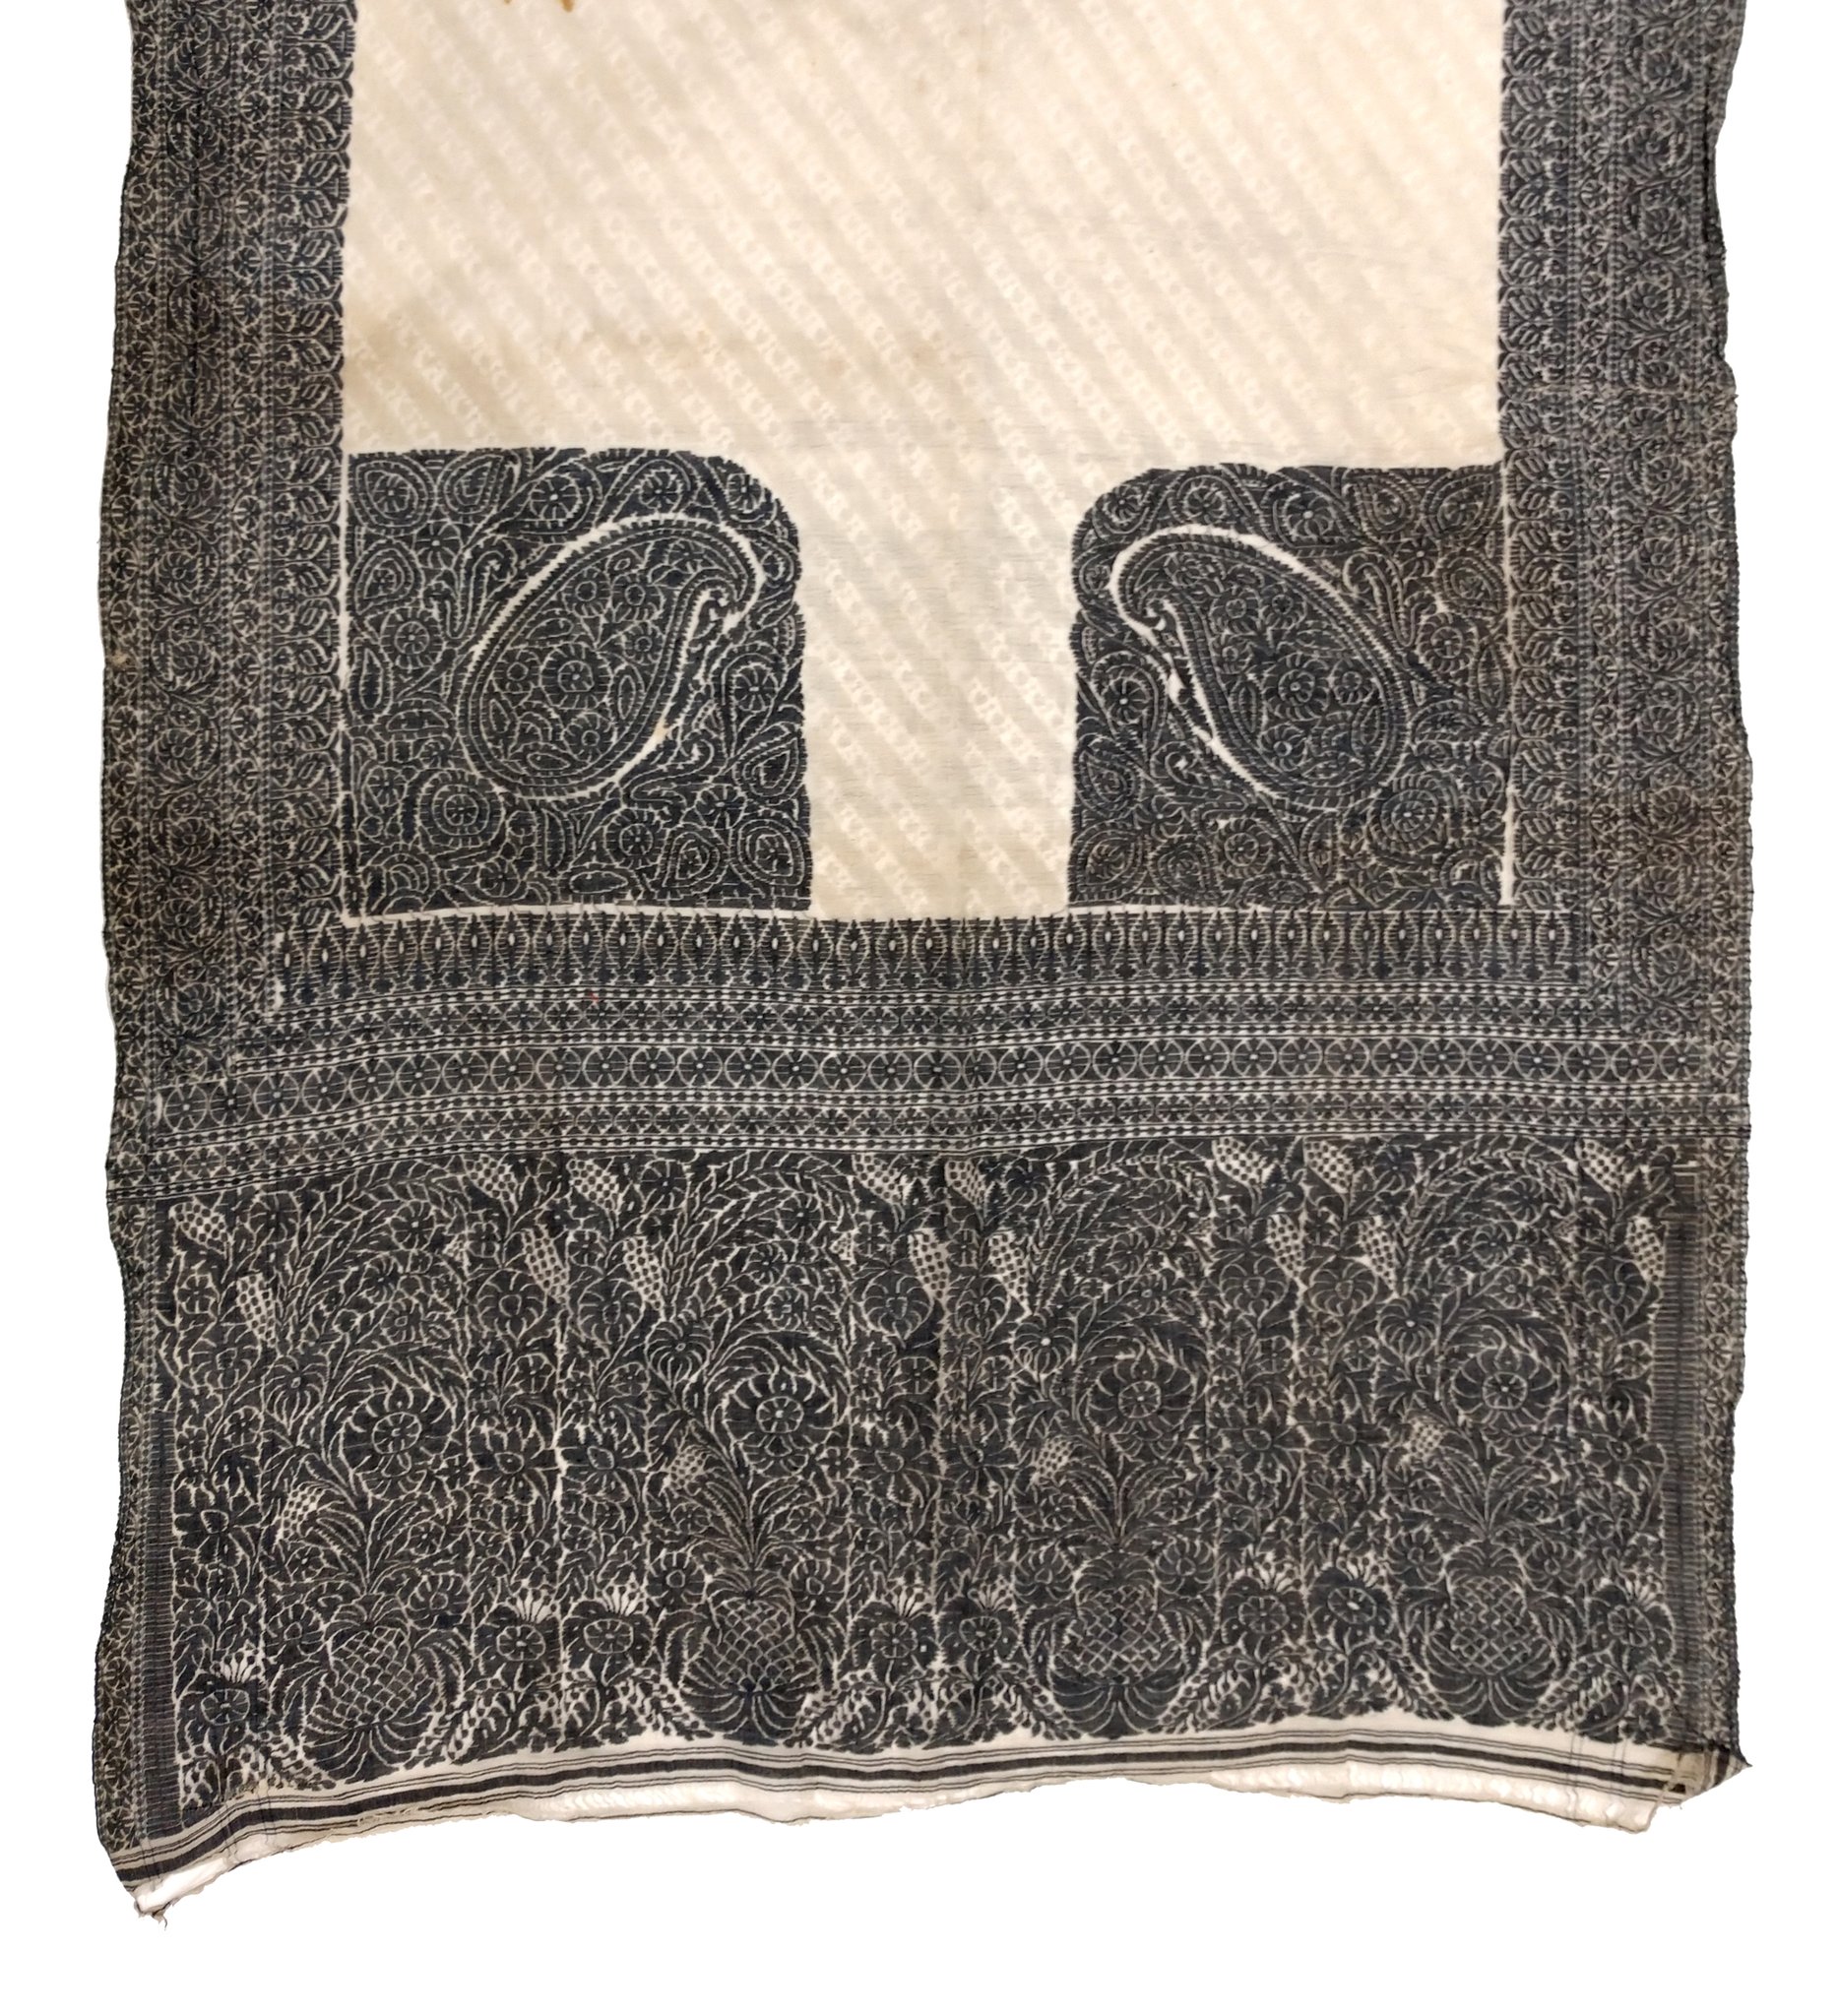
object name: textile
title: Sari-length textile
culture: bangladesh, dacca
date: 1801-1933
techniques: weave